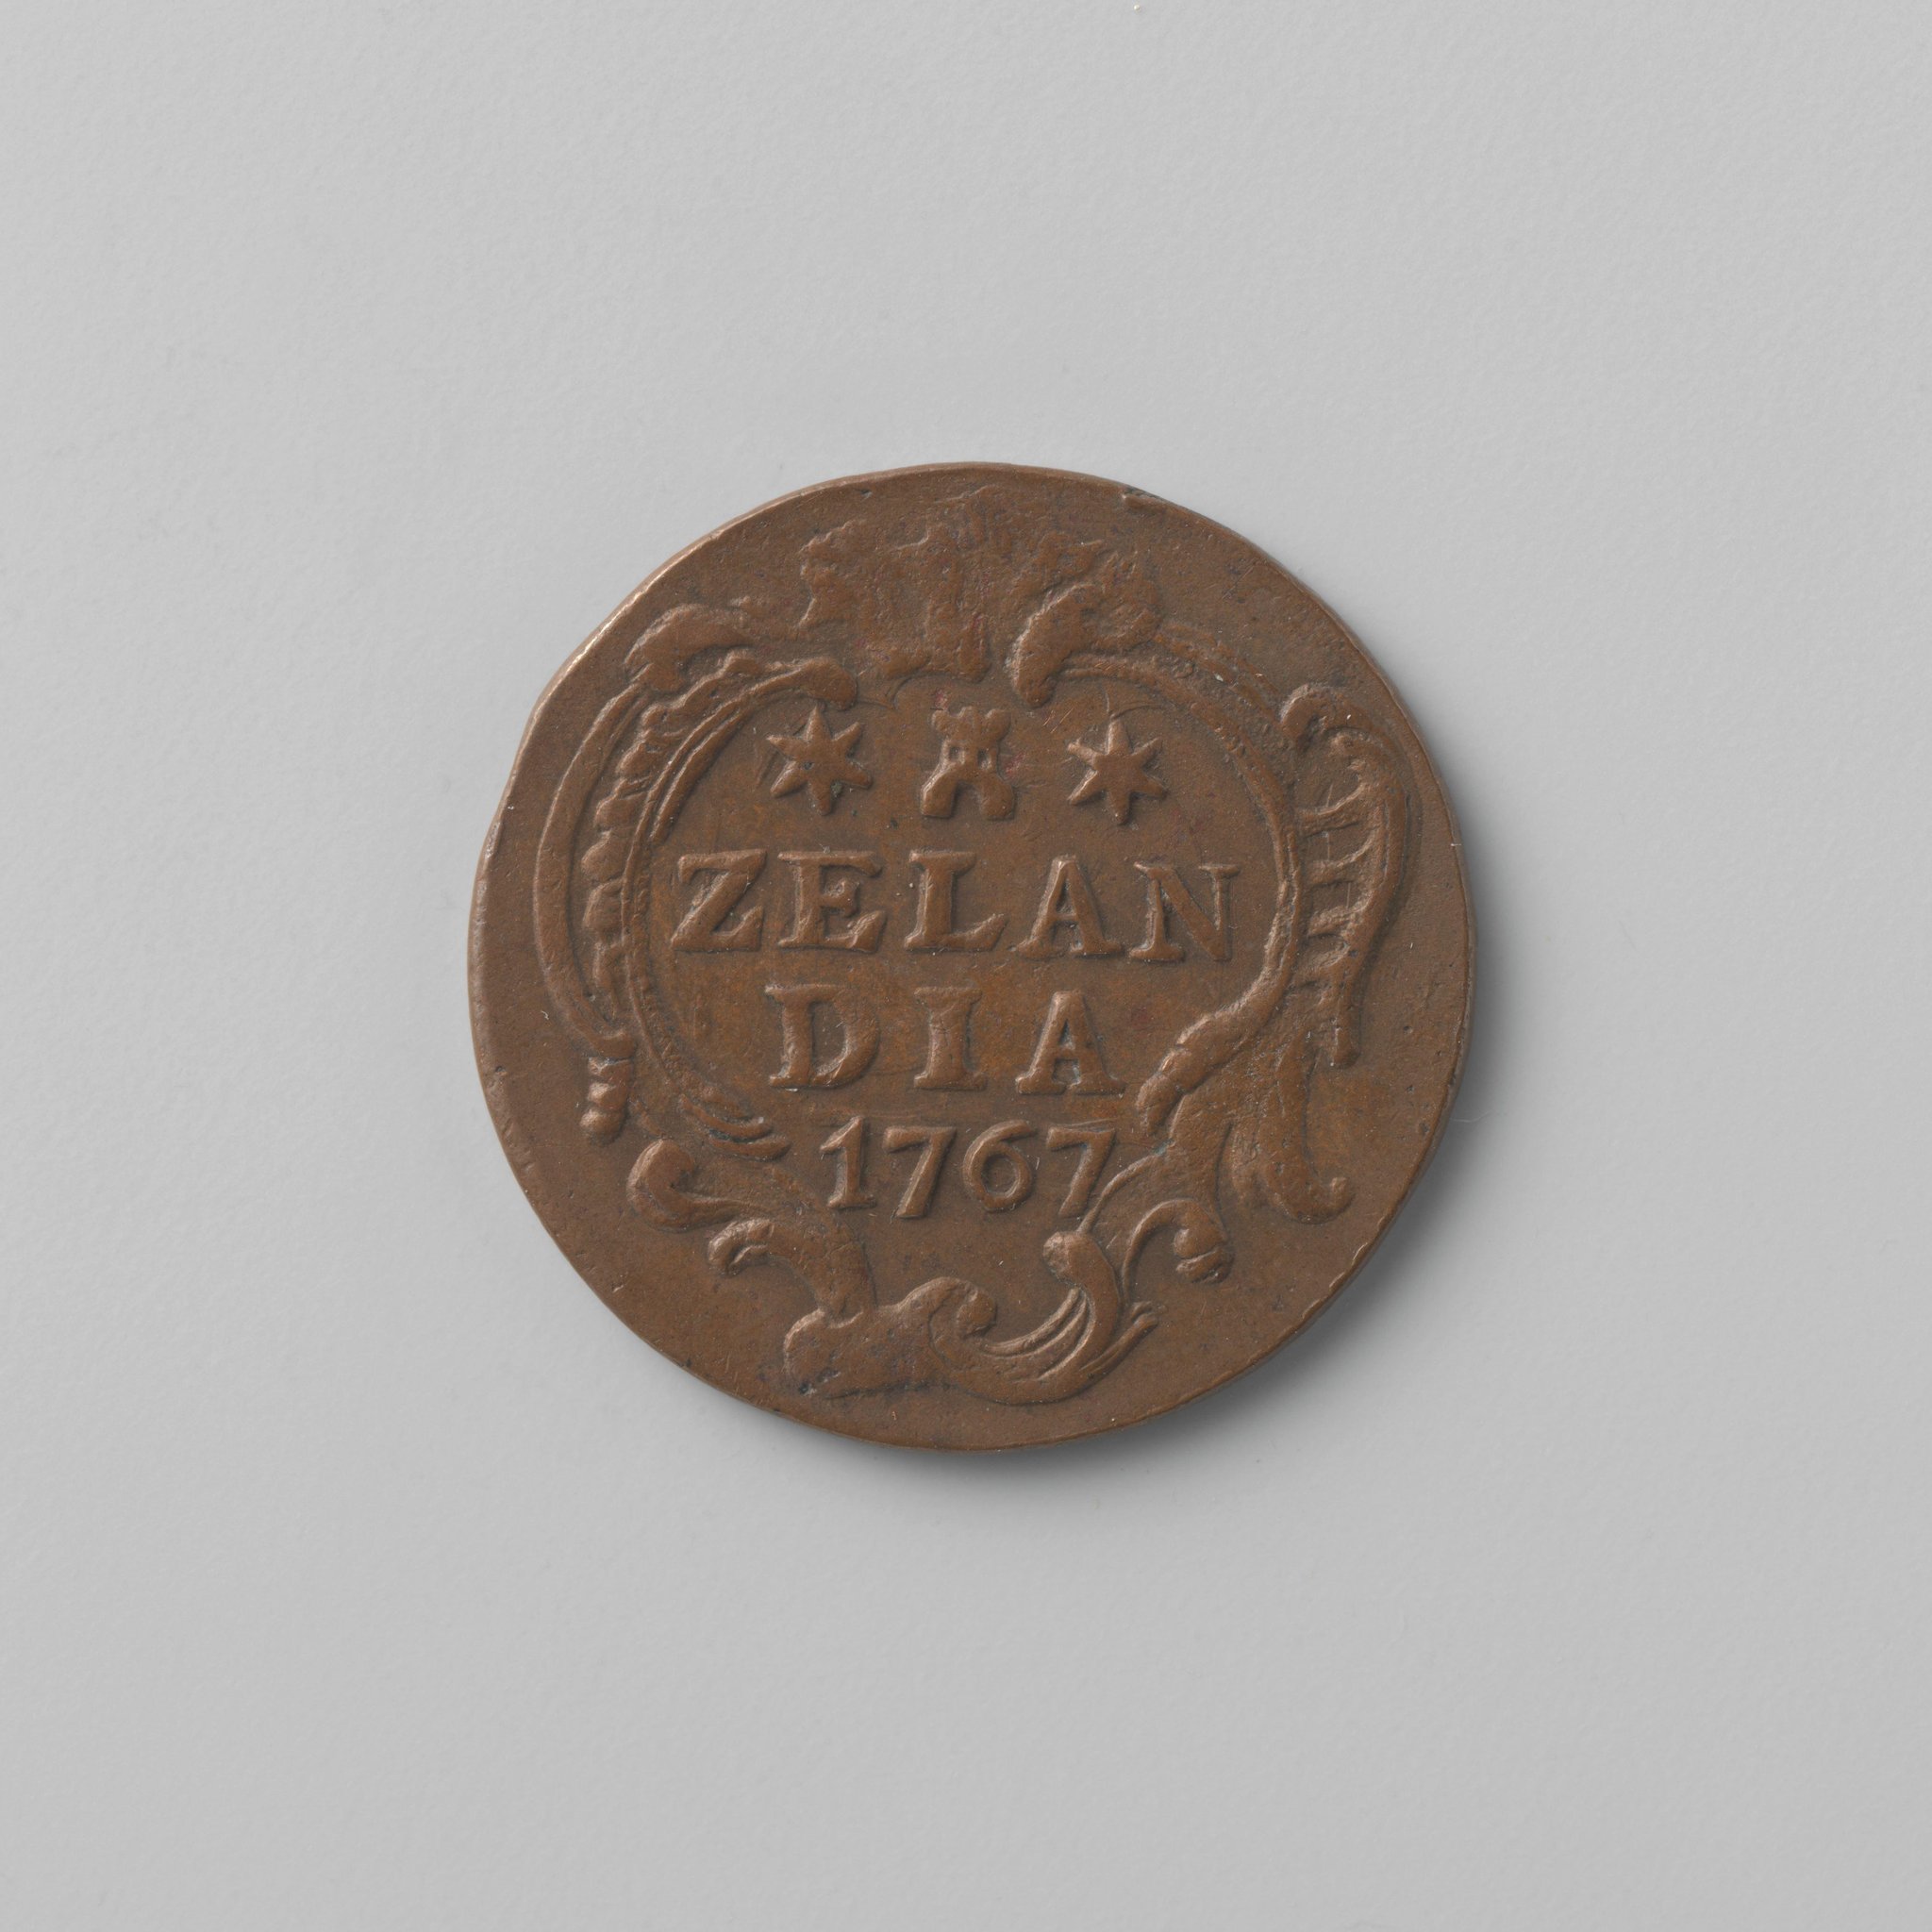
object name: coin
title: Zeeuwse duit, 1767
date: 1767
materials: copper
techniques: striking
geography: middelburg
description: Koperen munt. Voorzijde: in rococo-lijst gekroond ovaal wapenschild van Zeeland. Keerzijde: in een rococo-versiering opschrift in drie regels, waarboven muntteken burcht tussen twee sterren en waaronder jaartal.